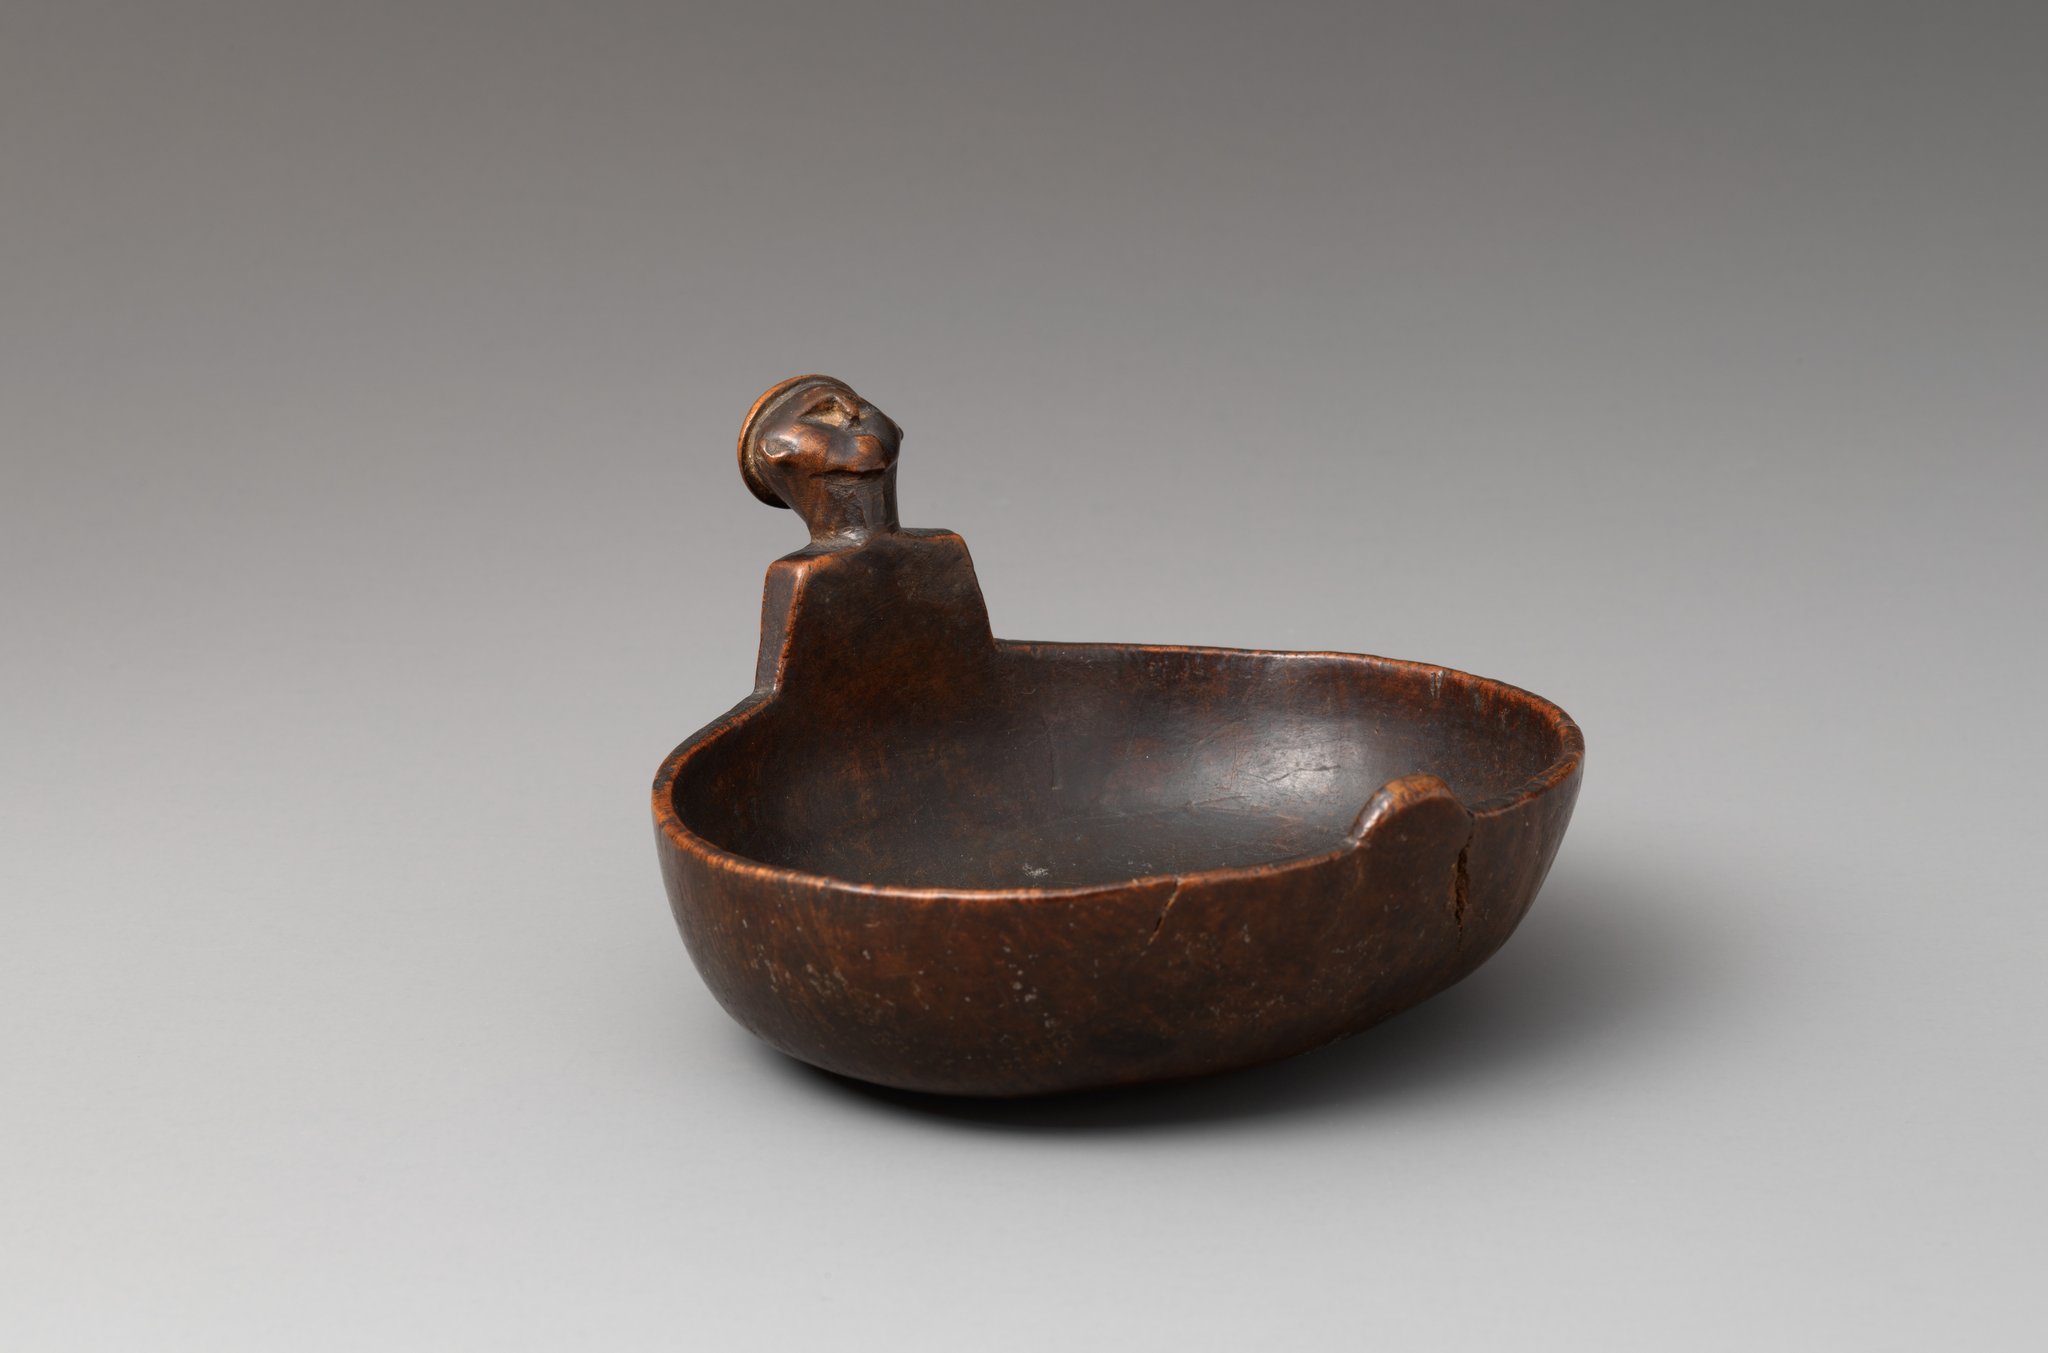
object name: bowl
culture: wendat or huron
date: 1700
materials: wood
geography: united states